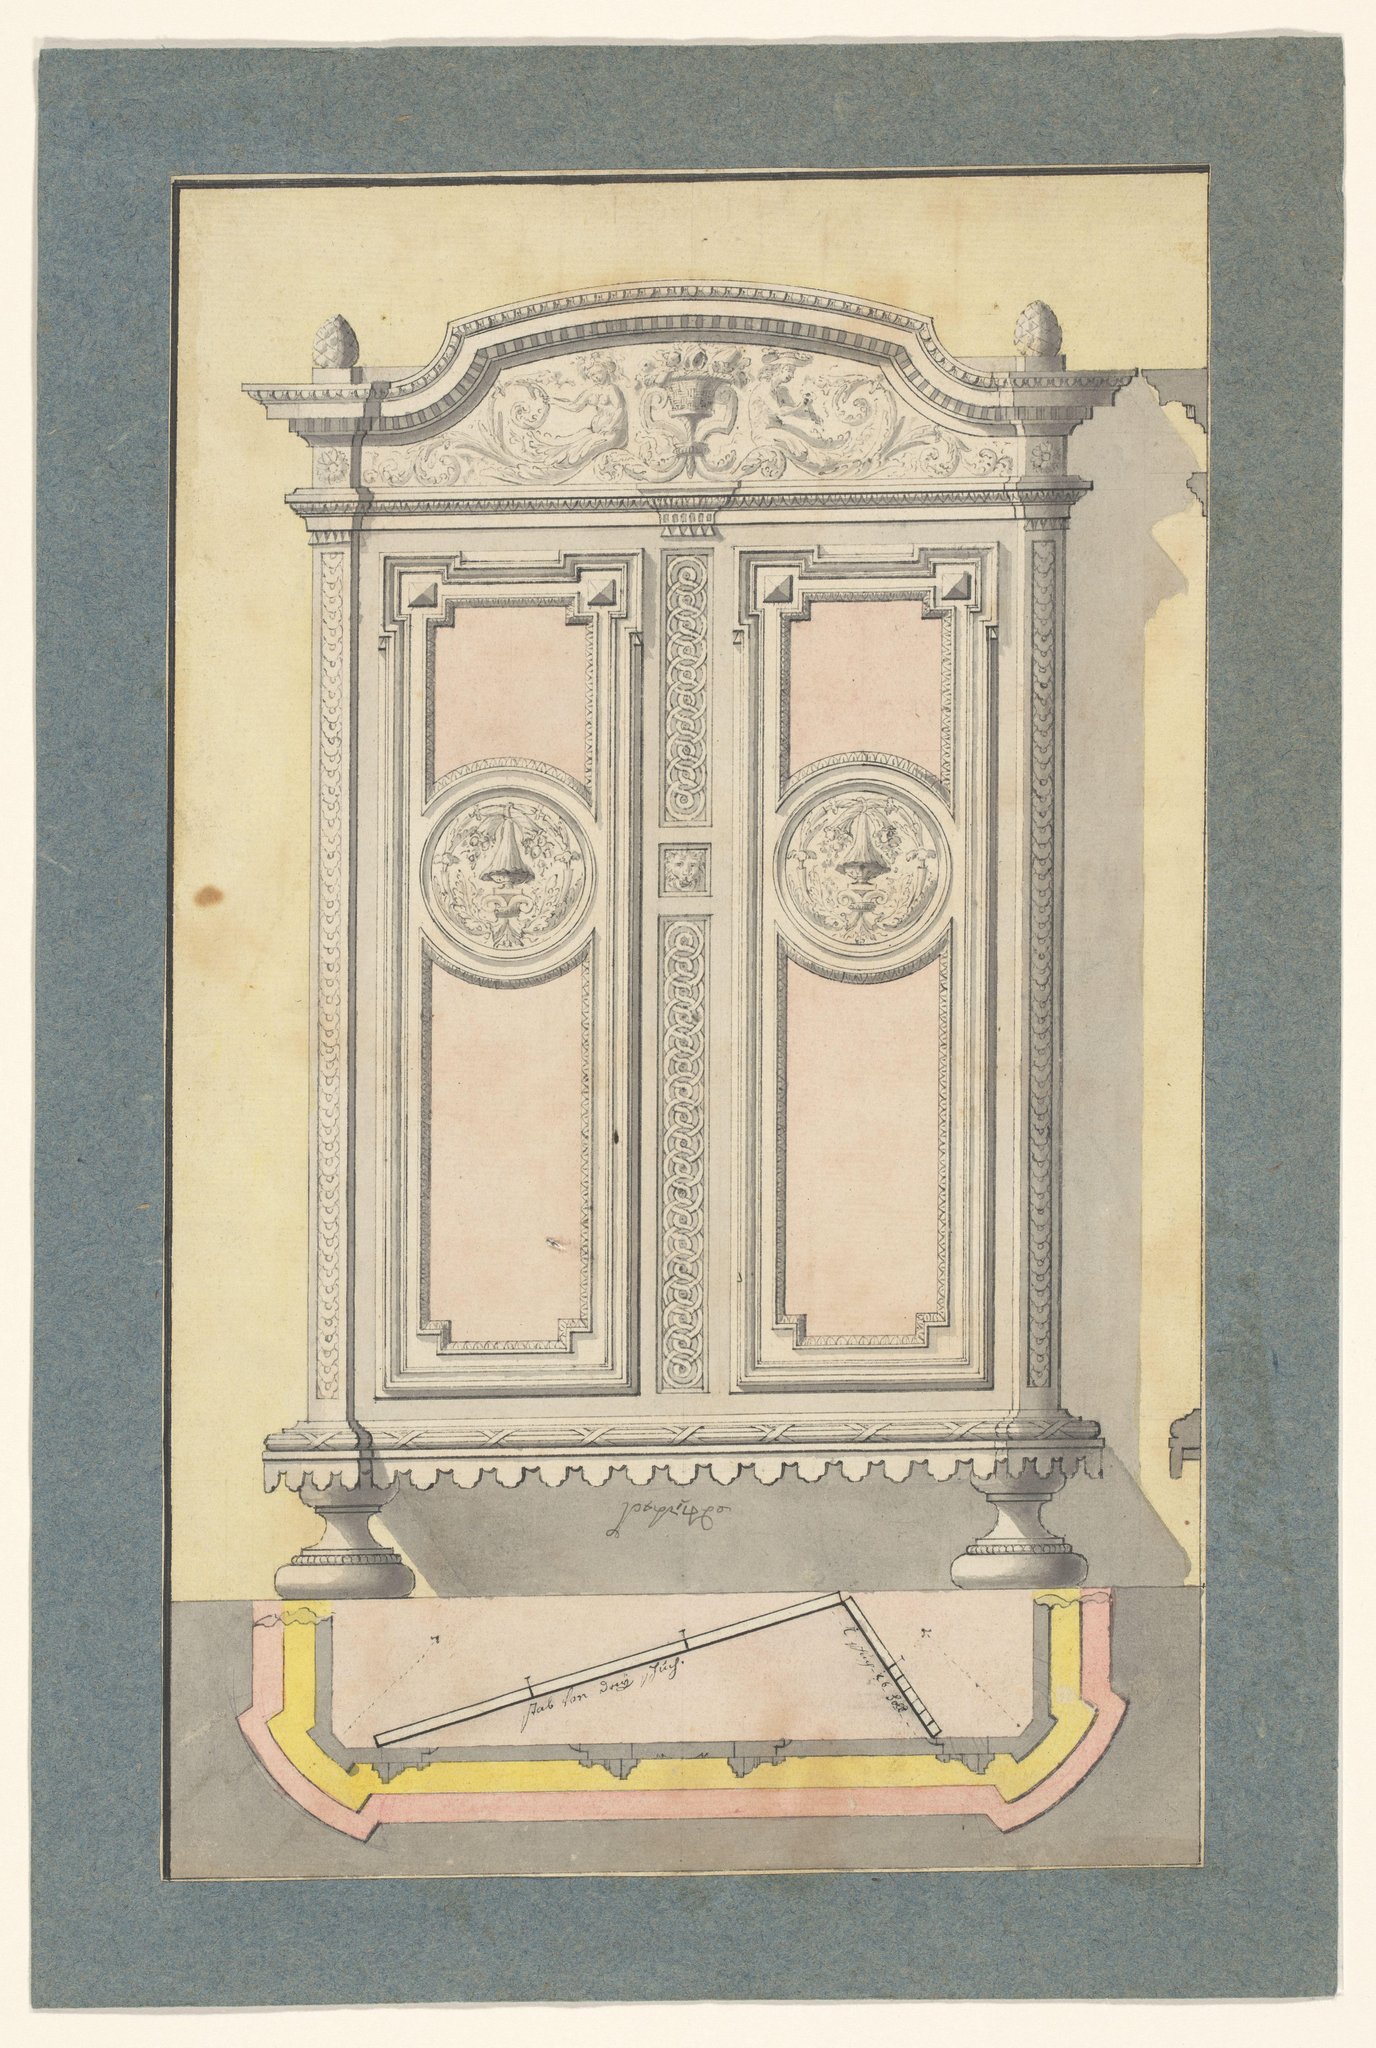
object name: design drawing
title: Ontwerp voor een tweedeurskast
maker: Anonymous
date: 1780-1790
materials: graphite, ink, paper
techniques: brush, pen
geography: germany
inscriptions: inscription: ‘Stab von dreij Fuss / 1 Fuss 16 Zol’